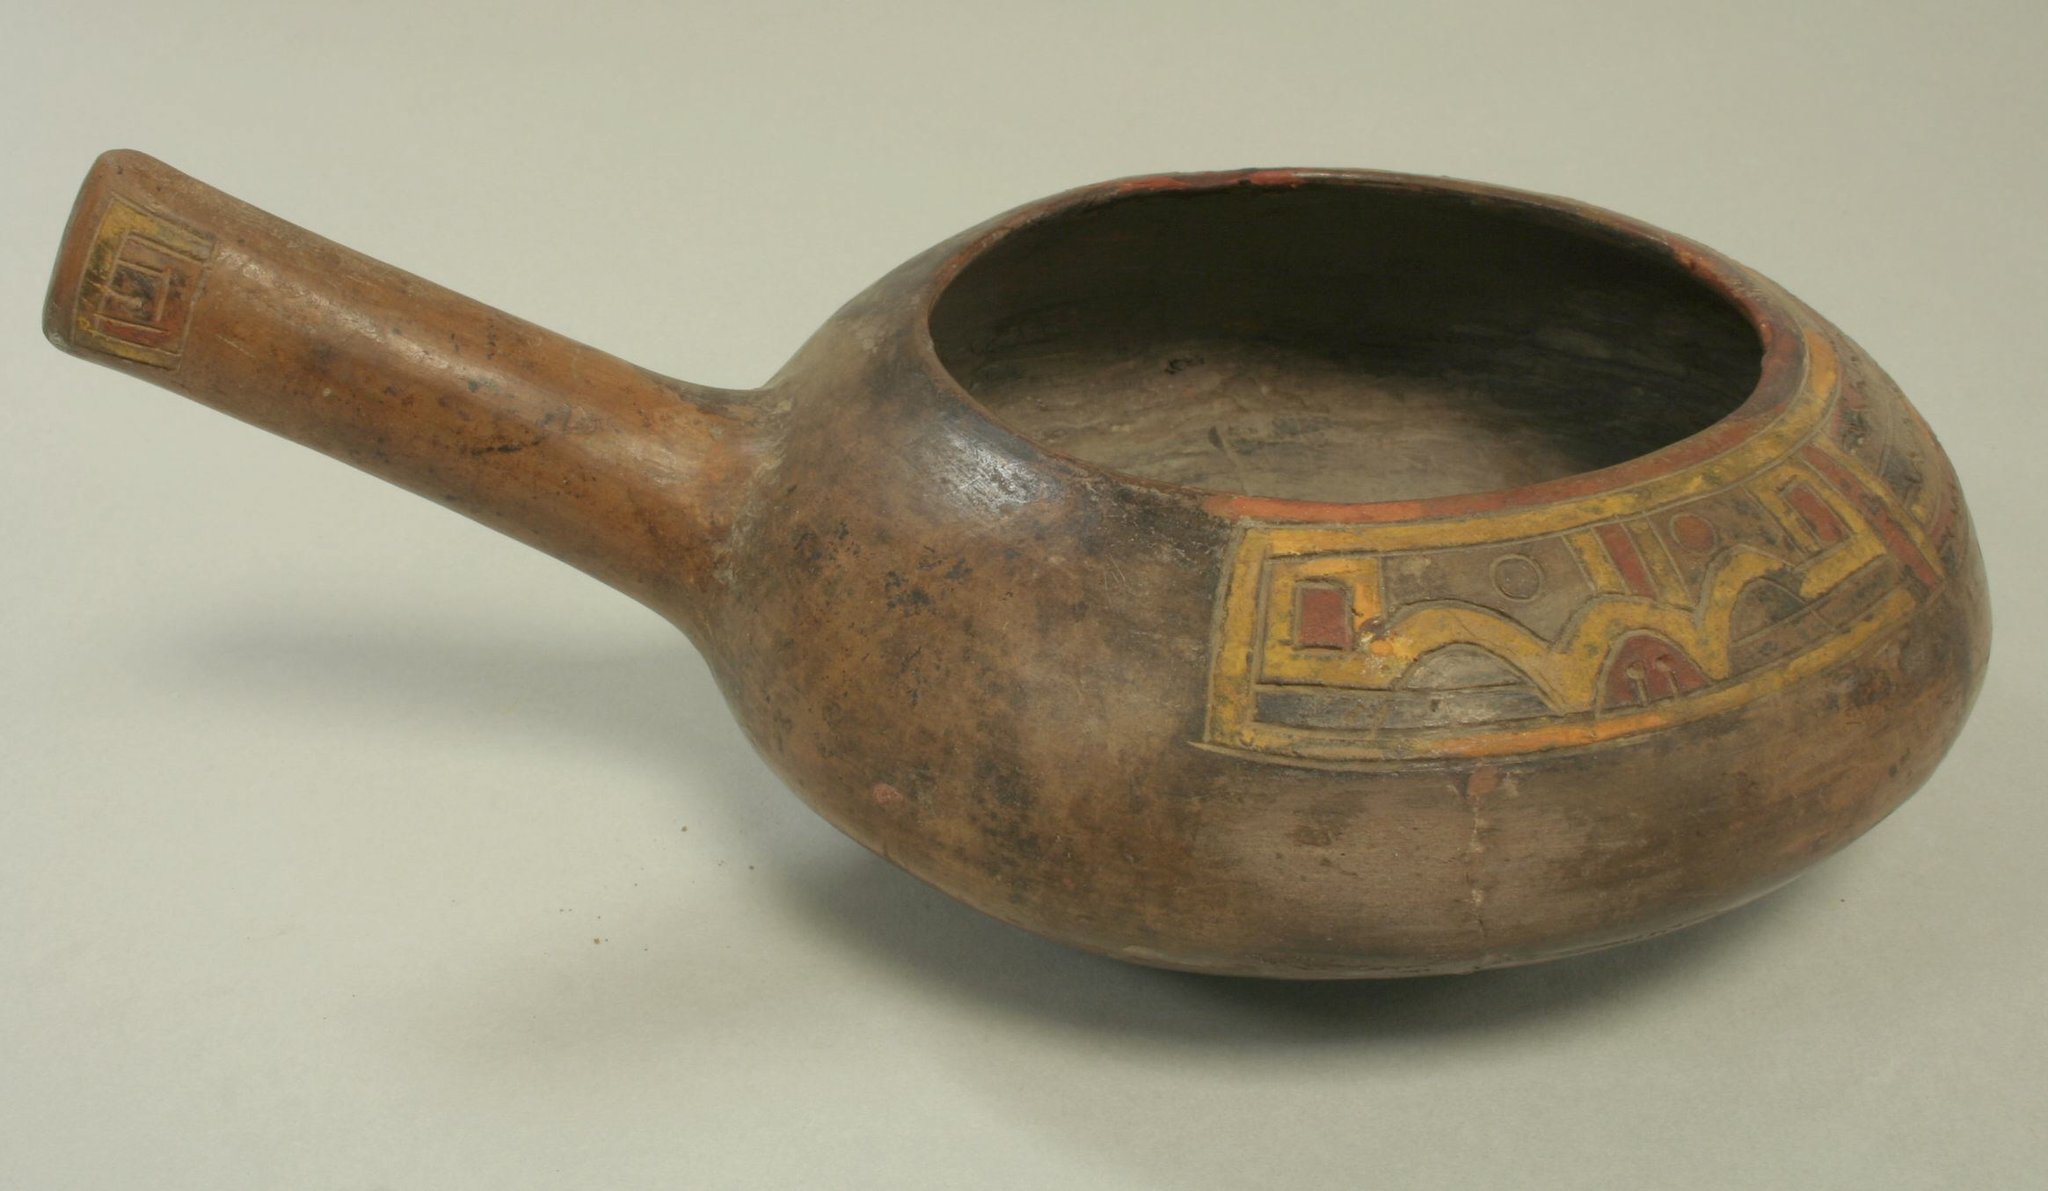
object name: vessel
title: Vessel with Handle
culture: paracas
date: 500-101 BCE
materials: ceramic, pigment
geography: peru